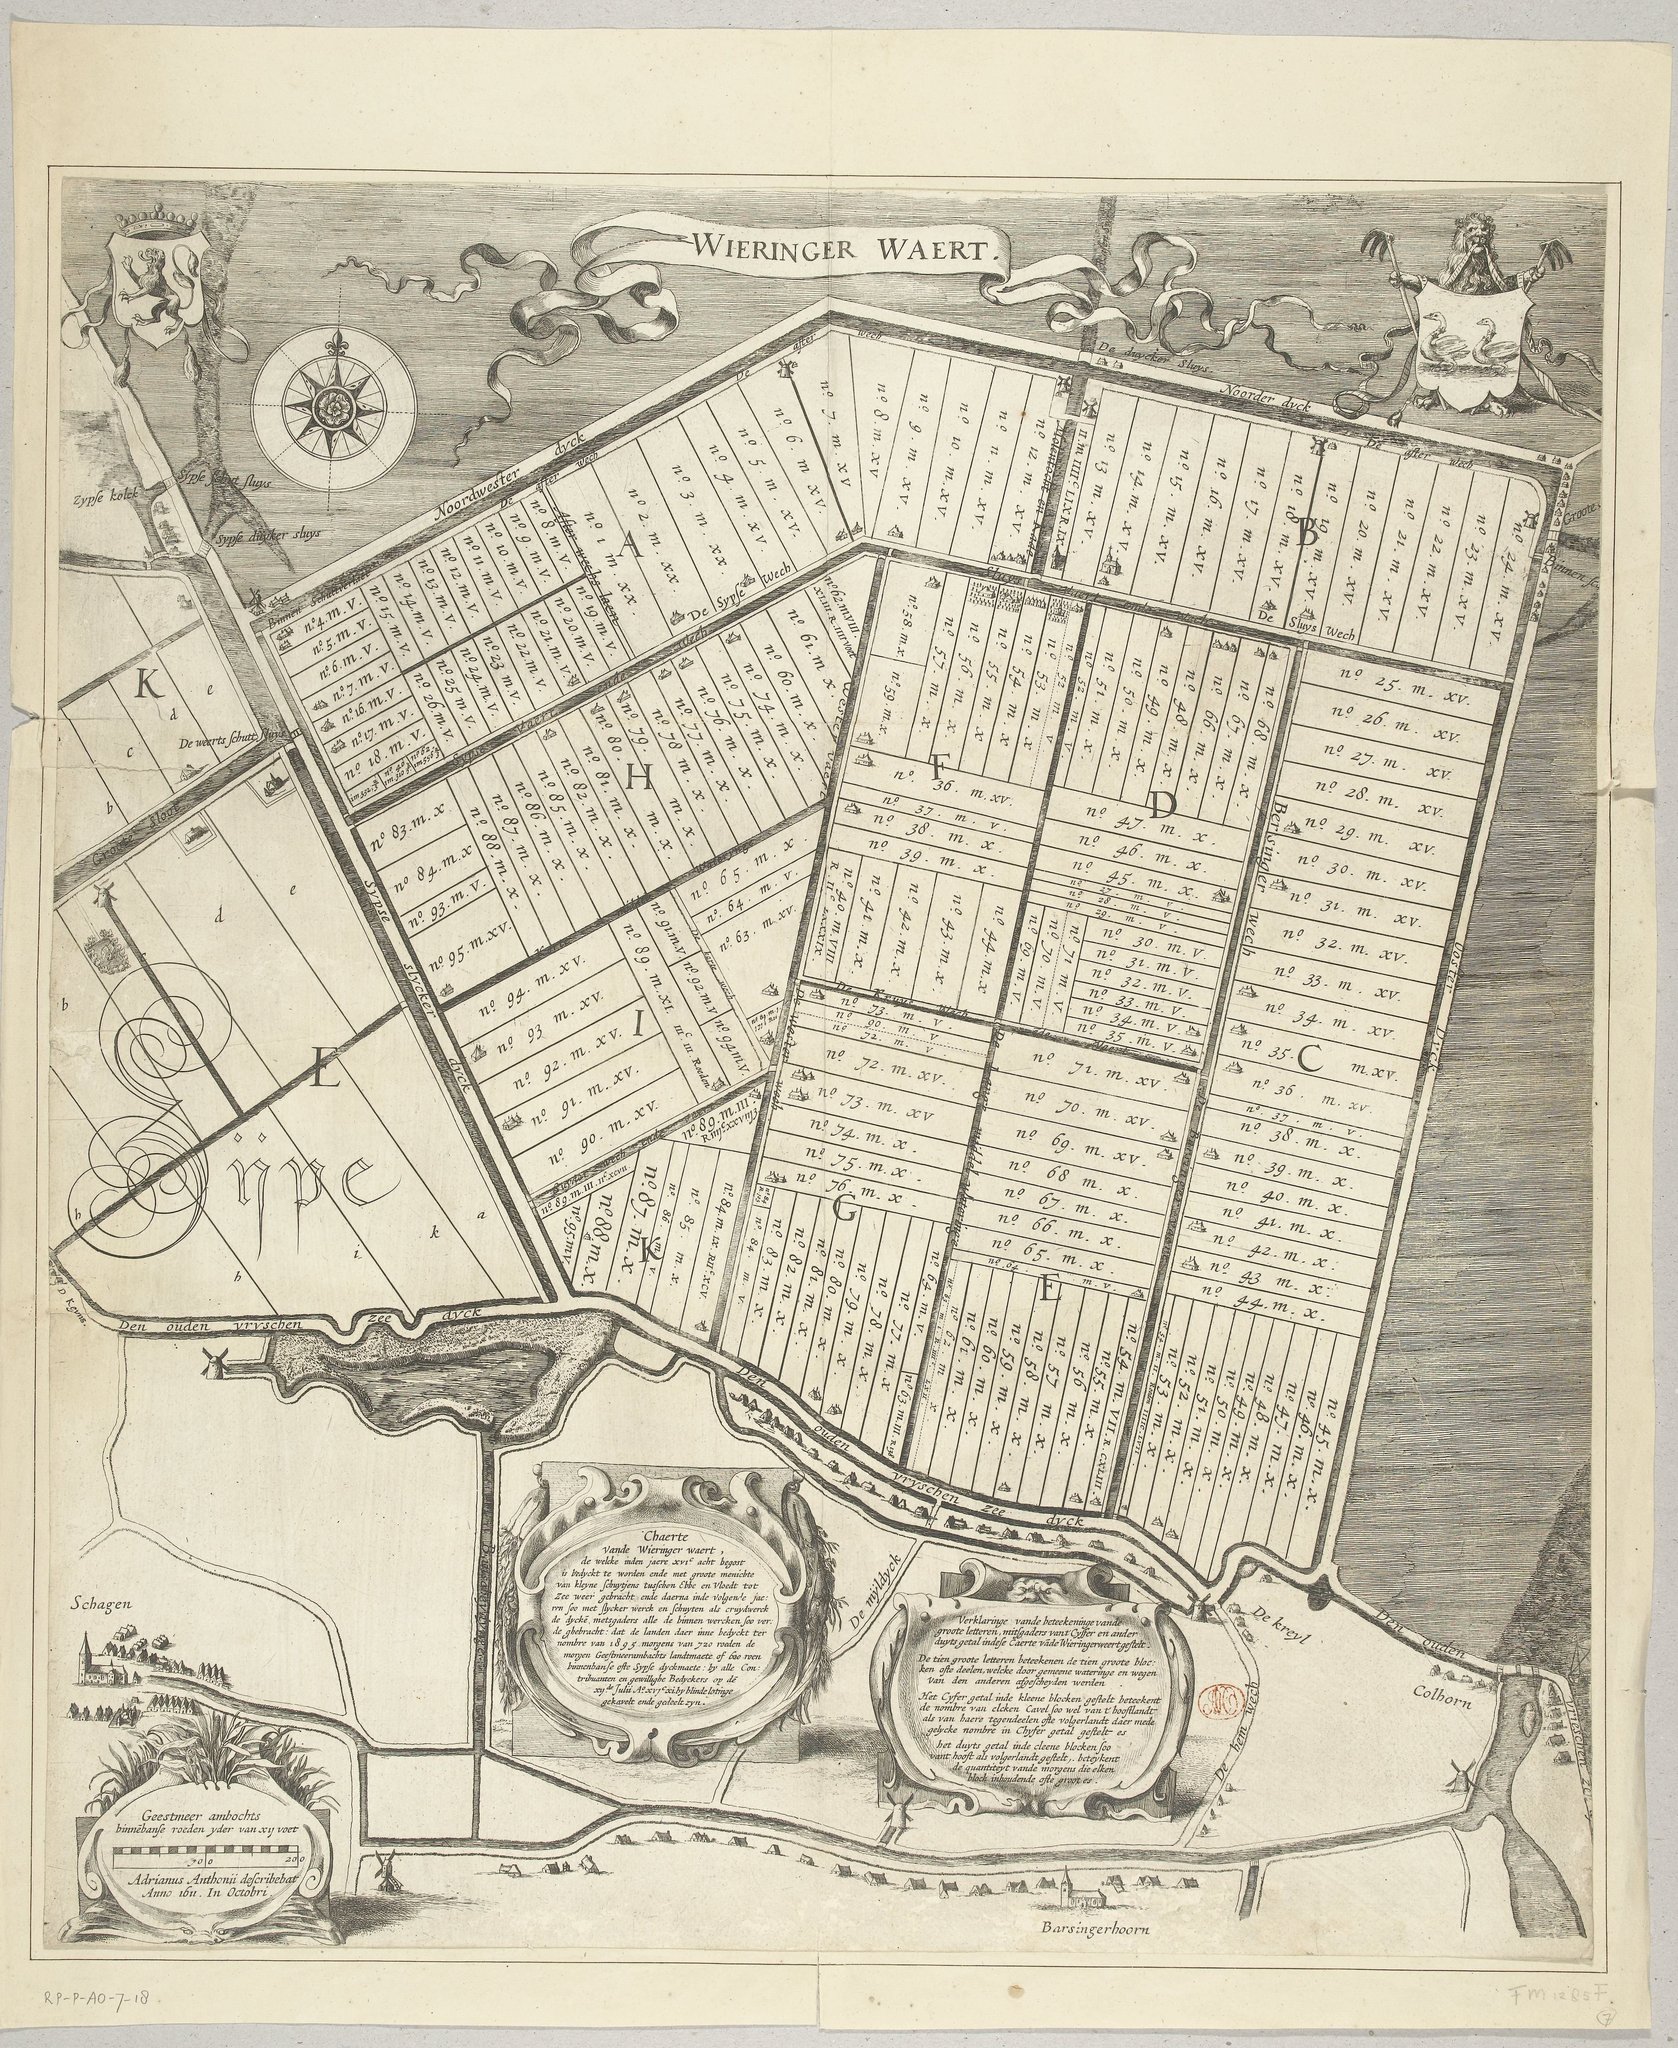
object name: map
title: Chaerte vande Wieringer waert, de welcke inden jaere xvi/c acht begost is bedyckt te worden (...) op de xijde julii Ao. xvj/c xi by blinde lotinge gekavelt ende gedeelt zyn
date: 1610-1611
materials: paper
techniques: engraving, etching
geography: alkmaar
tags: coat of arms (as symbol of the state, etc.), raffle, lottery, maps of separate countries or regions, polder, reclaimed land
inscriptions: collector's mark: Lugt 195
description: Aangezien op deze kaart vermeld staat dat landmeter Adriaan Anthonisz. de kaart in oktober 1611 tekende, moet de kaart daarna gedrukt zijn. Wanneer precies is onduidelijk. Er is een ander exemplaar bekend waarop ook de wapens van het toenmalige polderbestuur gedrukt zijn (RP-P-AO-7-18). Dit exemplaar kan aan de hand van de samenstelling van het bestuur preciezer gedateerd worden: 1741-1747. Voor een verkleinde versie van deze kaart zie RP-P-AO-7-19X.